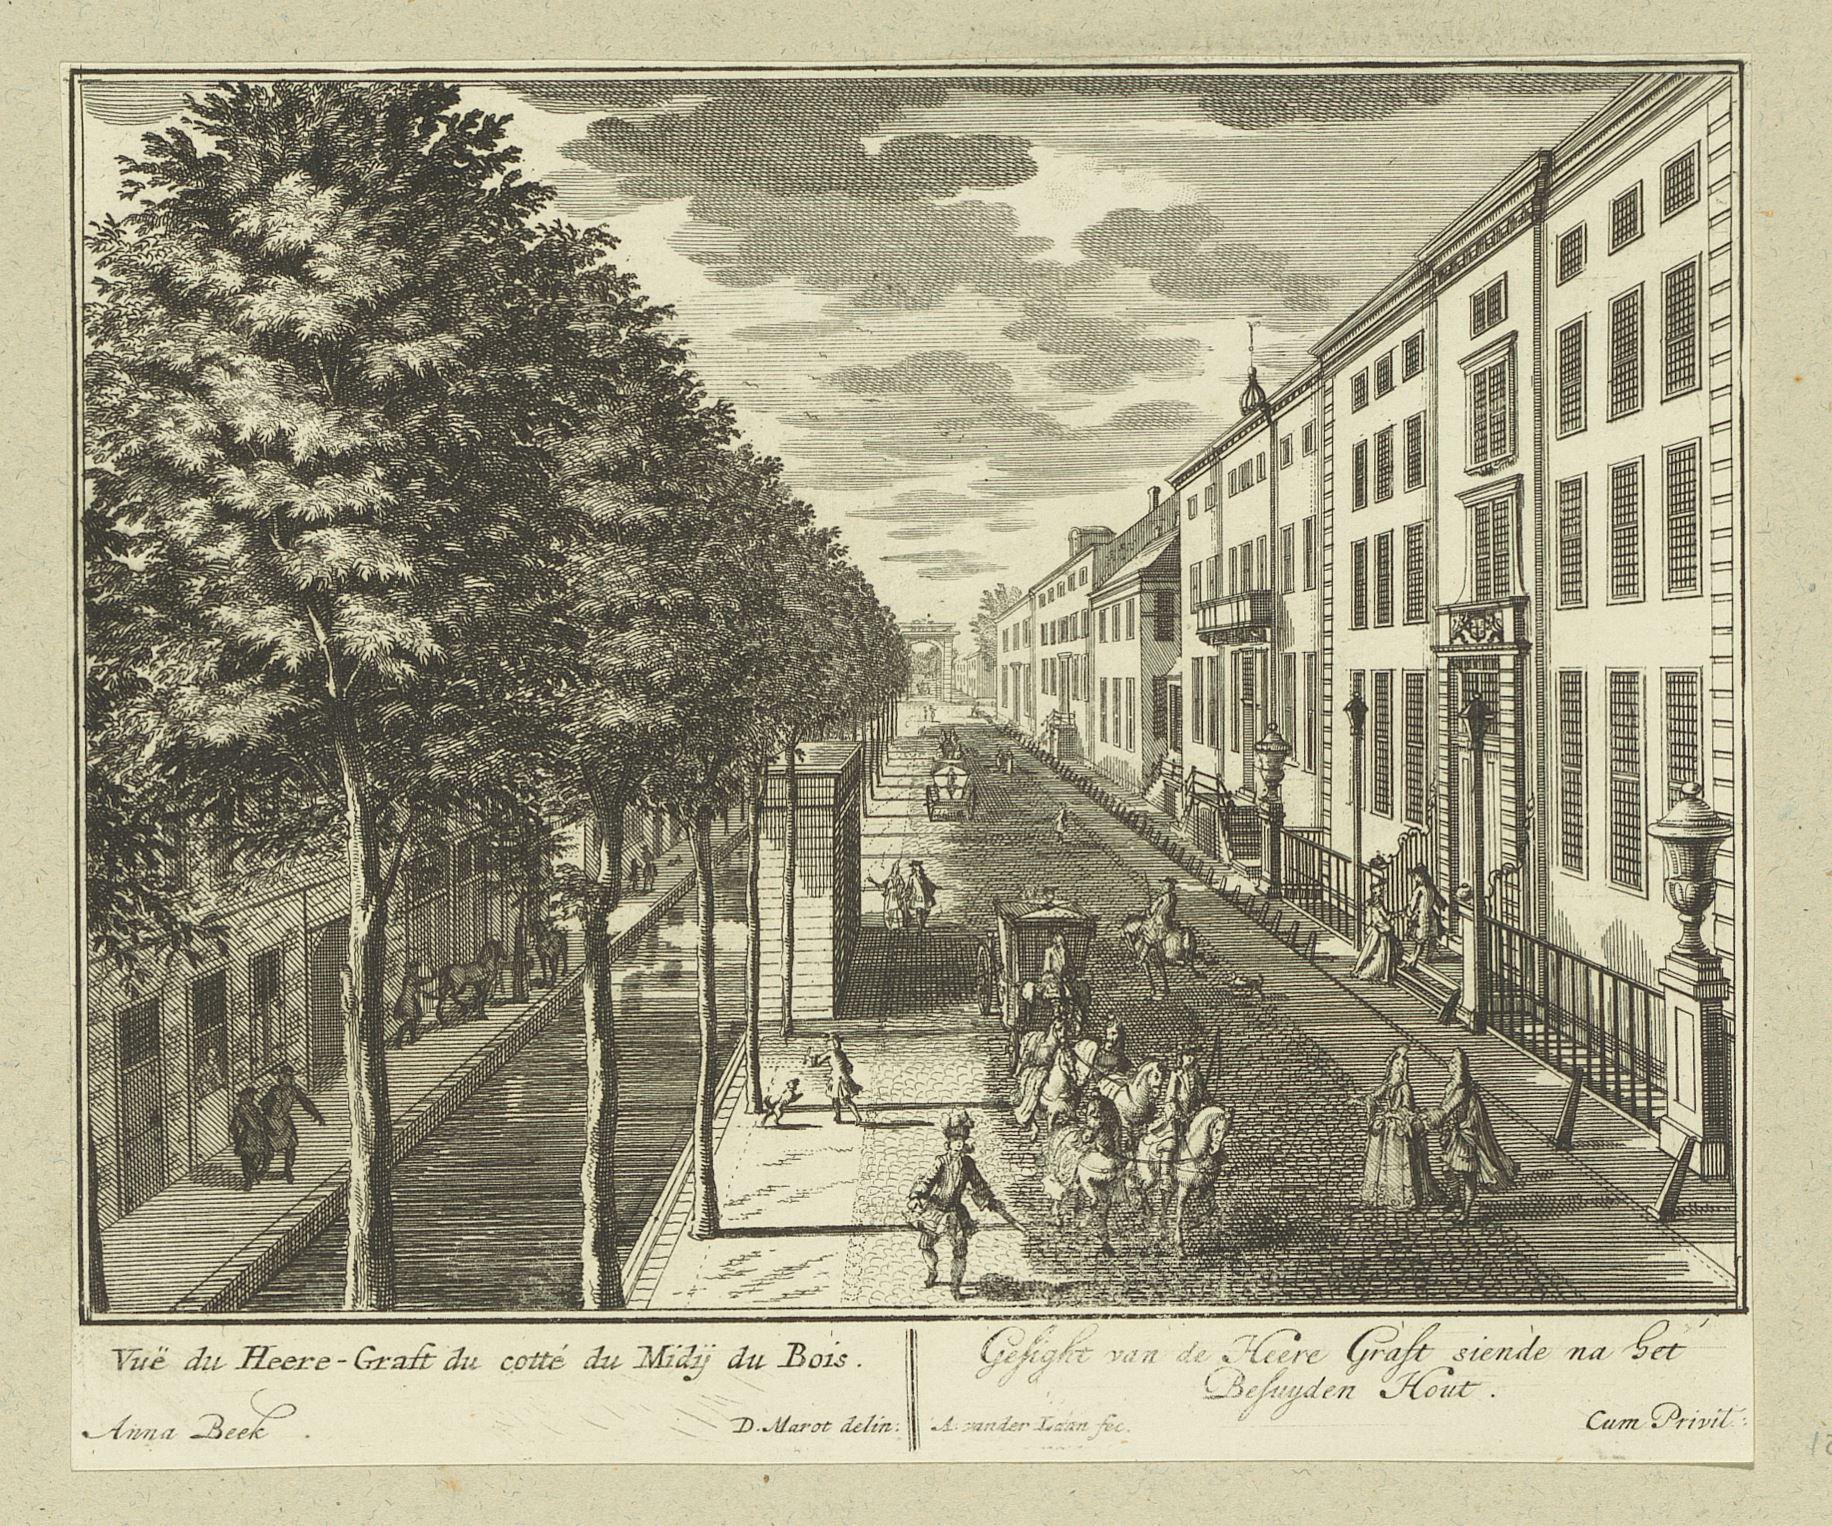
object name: print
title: Gezicht op de Herengracht te Den Haag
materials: paper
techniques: engraving, etching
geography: the hague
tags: canals, waters (in city), street (+ city(-scape) with figures, staffage)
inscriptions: collector's mark: Lugt 2228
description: Mogelijk uitgegeven als onderdeel van een serie van veertien gezichten in Den Haag. Zie ook RP-P-AO-12-34A, RP-P-AO-12-118-1, RP-P-AO-12-118-2, RP-P-AO-12-118-3, RP-P-AO-12-118-4, RP-P-AO-12-118-5, RP-P-AO-12-118-6, RP-P-AO-12-118-7, RP-P-AO-12-118-8, RP-P-AO-12-118-9, RP-P-AO-12-118-10, RP-P-AO-12-118-11, RP-P-AO-12-118-13, RP-P-2016-2145, RP-P-2016-2146, RP-P-2016-2147, RP-P-2016-2148, RP-P-2016-2149, RP-P-2016-2150 en RP-P-2016-2151.